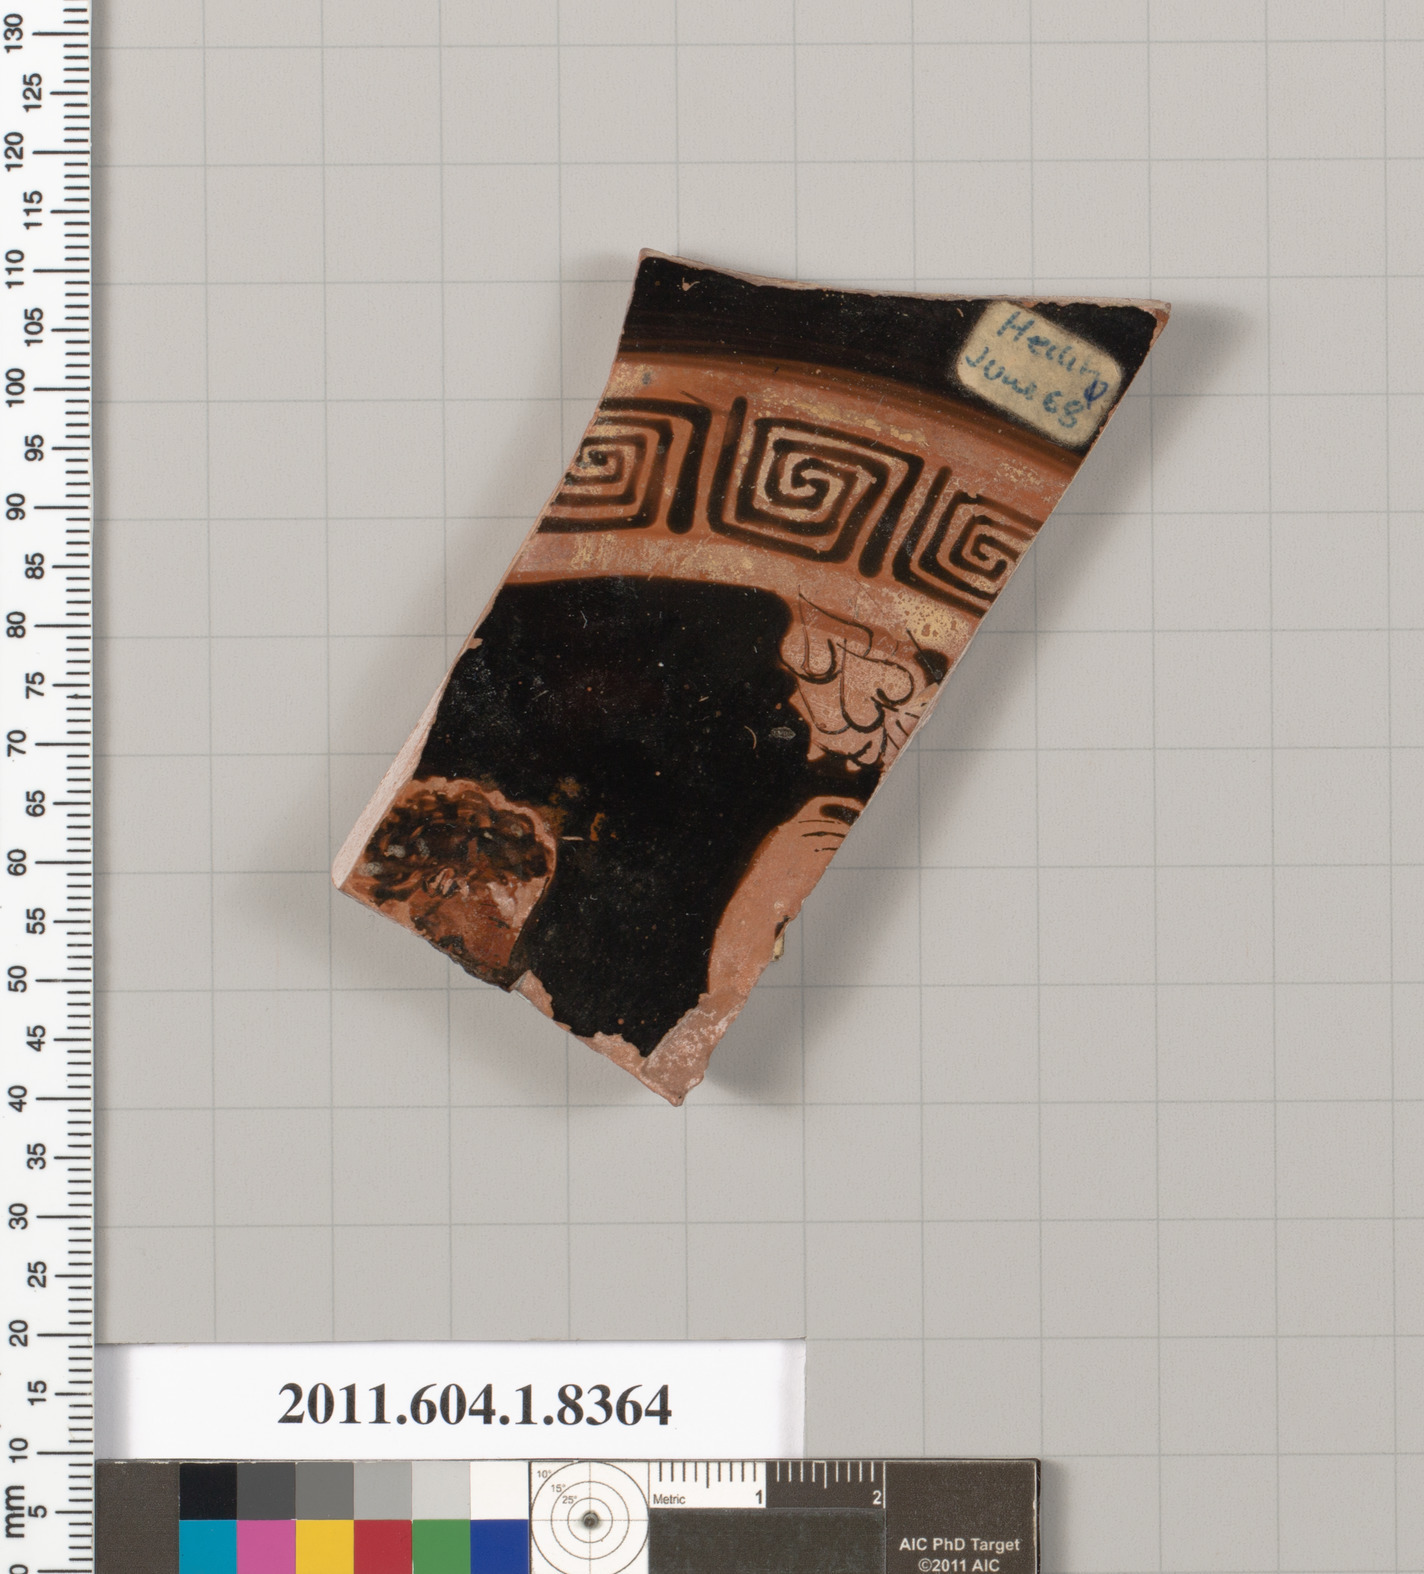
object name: kylix fragment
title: Terracotta fragment of a kylix (drinking cup)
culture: greek, attic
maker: painter of london e 106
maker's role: artist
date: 410-400 BCE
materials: terracotta